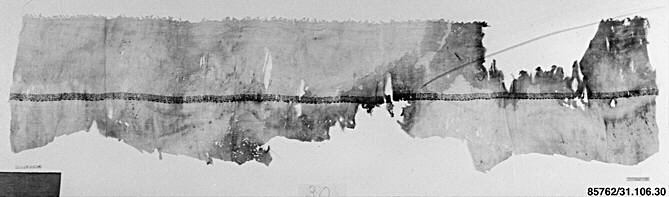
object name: textile fragment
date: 1001-1100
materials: linen, silk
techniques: weave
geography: egypt